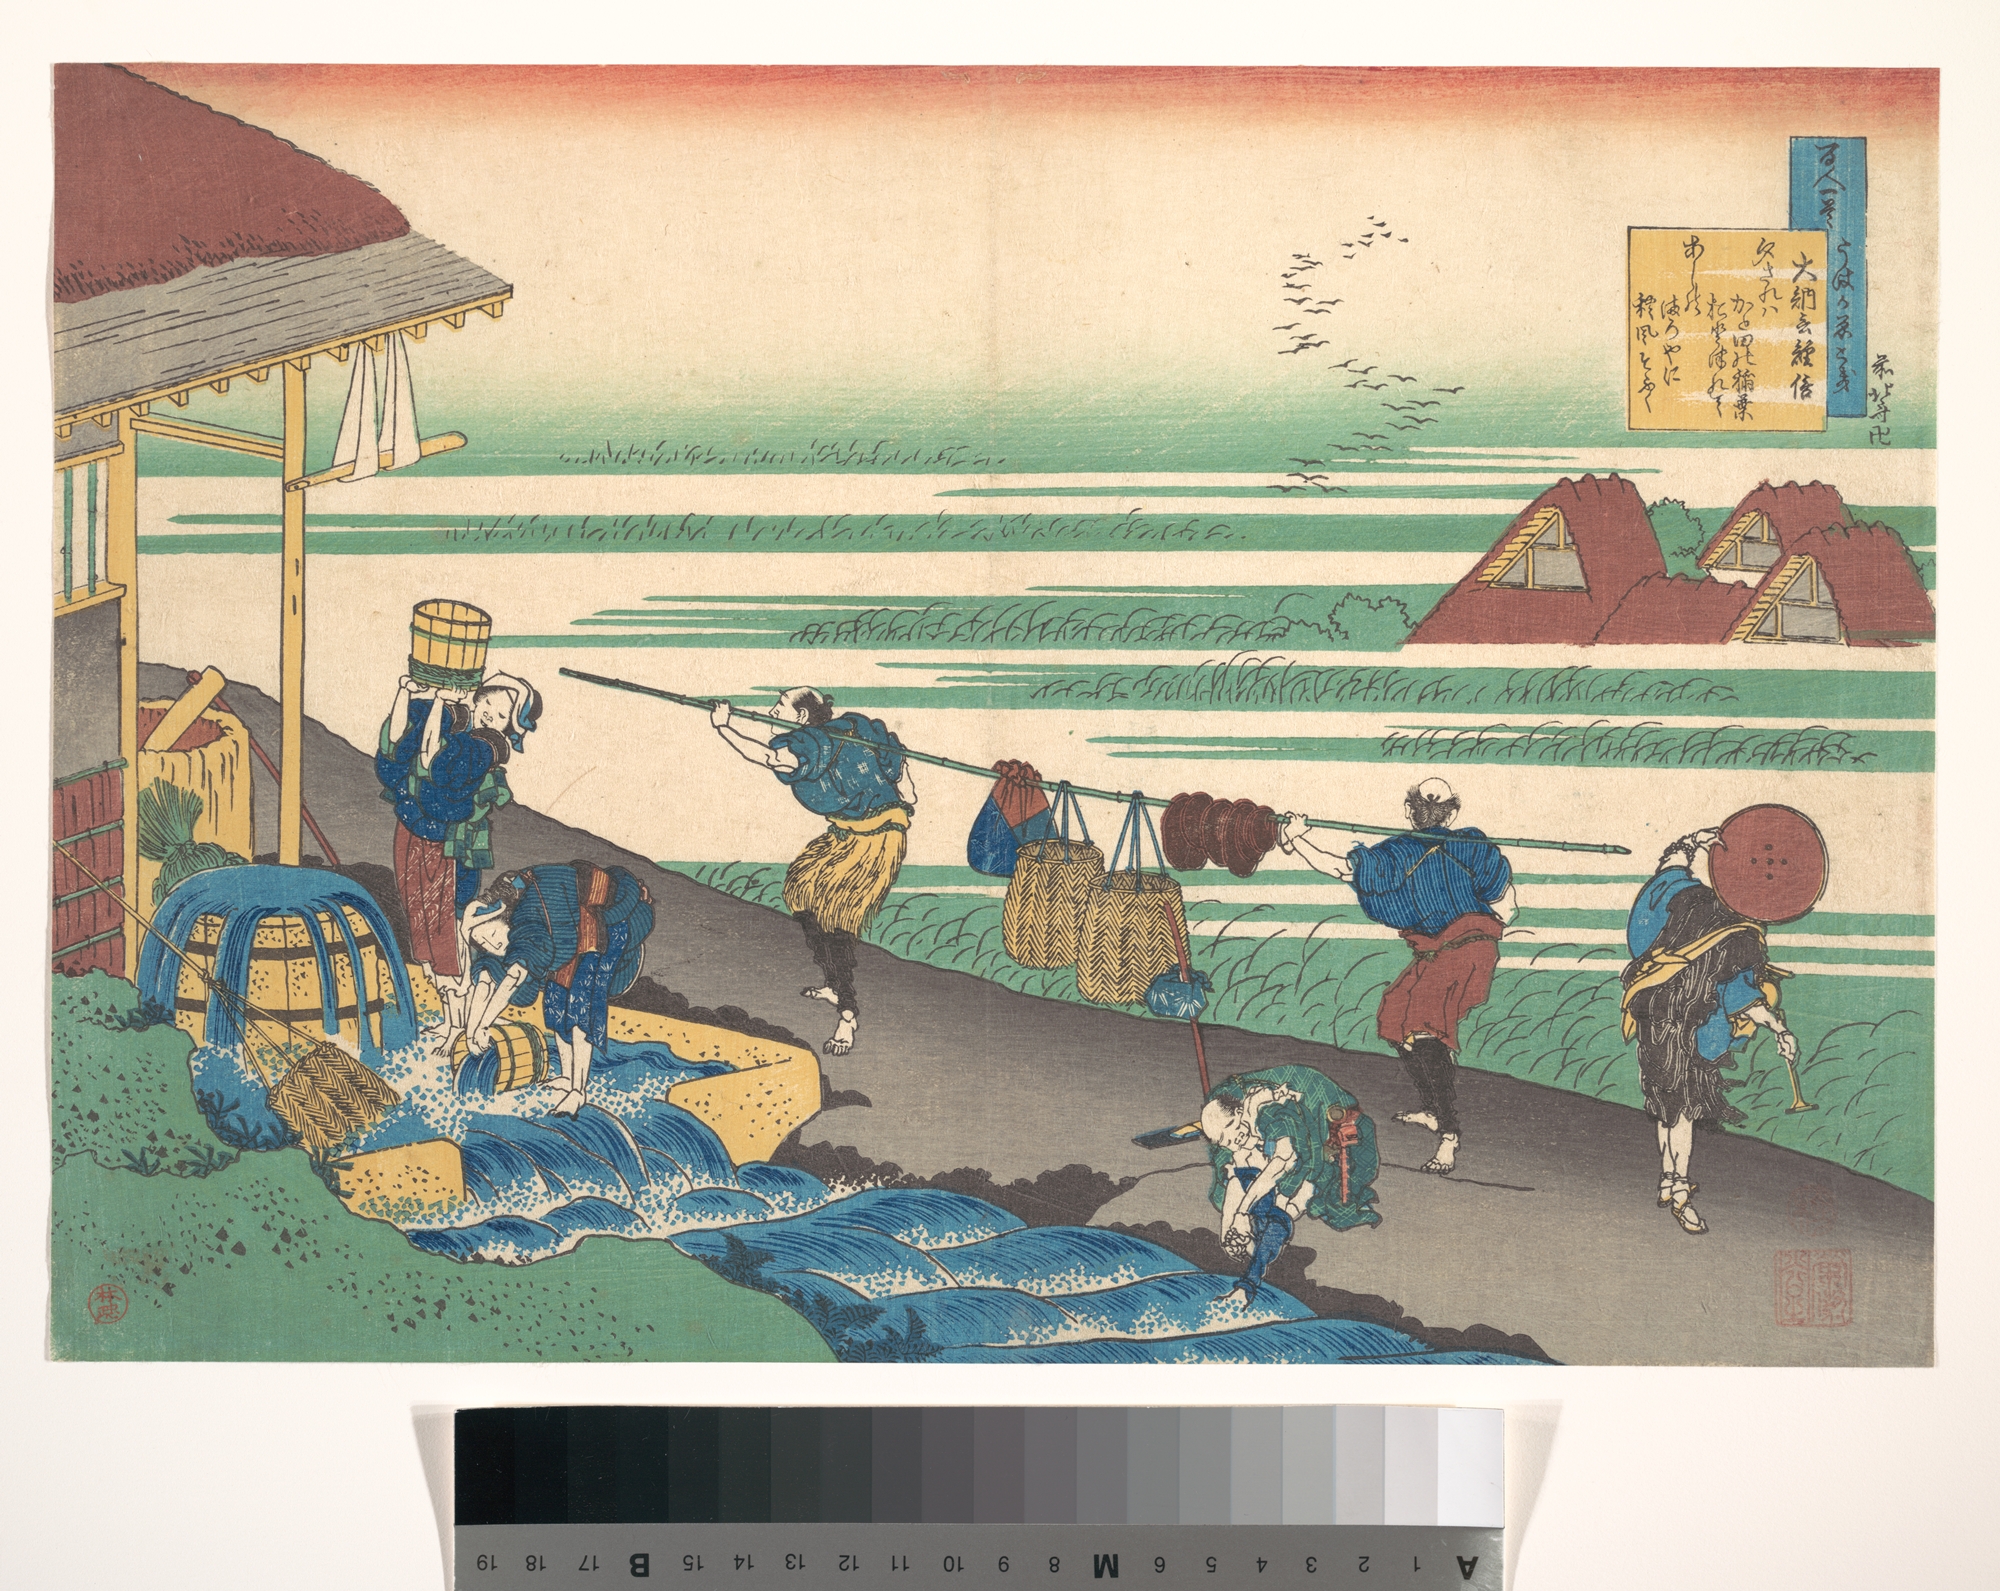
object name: woodblock print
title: Poem by Dainagon Tsunenobu (Minamoto no Tsunenobu, Katsura no Dainagon), from the series One Hundred Poems Explained by the Nurse (Hyakunin isshu uba ga etoki)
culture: japanese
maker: katsushika hokusai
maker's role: artist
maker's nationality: japanese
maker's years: 1760-1849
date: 1839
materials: ink, paper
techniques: woodblock print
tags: houses,men,women,working